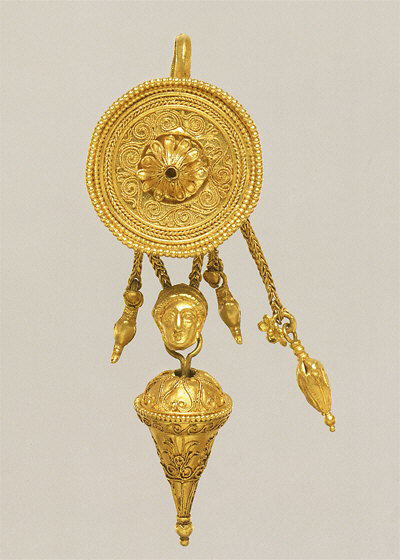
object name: disk earring with female head and cone pendant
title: Gold disk earring with a female head and cone pendants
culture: greek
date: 350-300 BCE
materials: gold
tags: heads,women